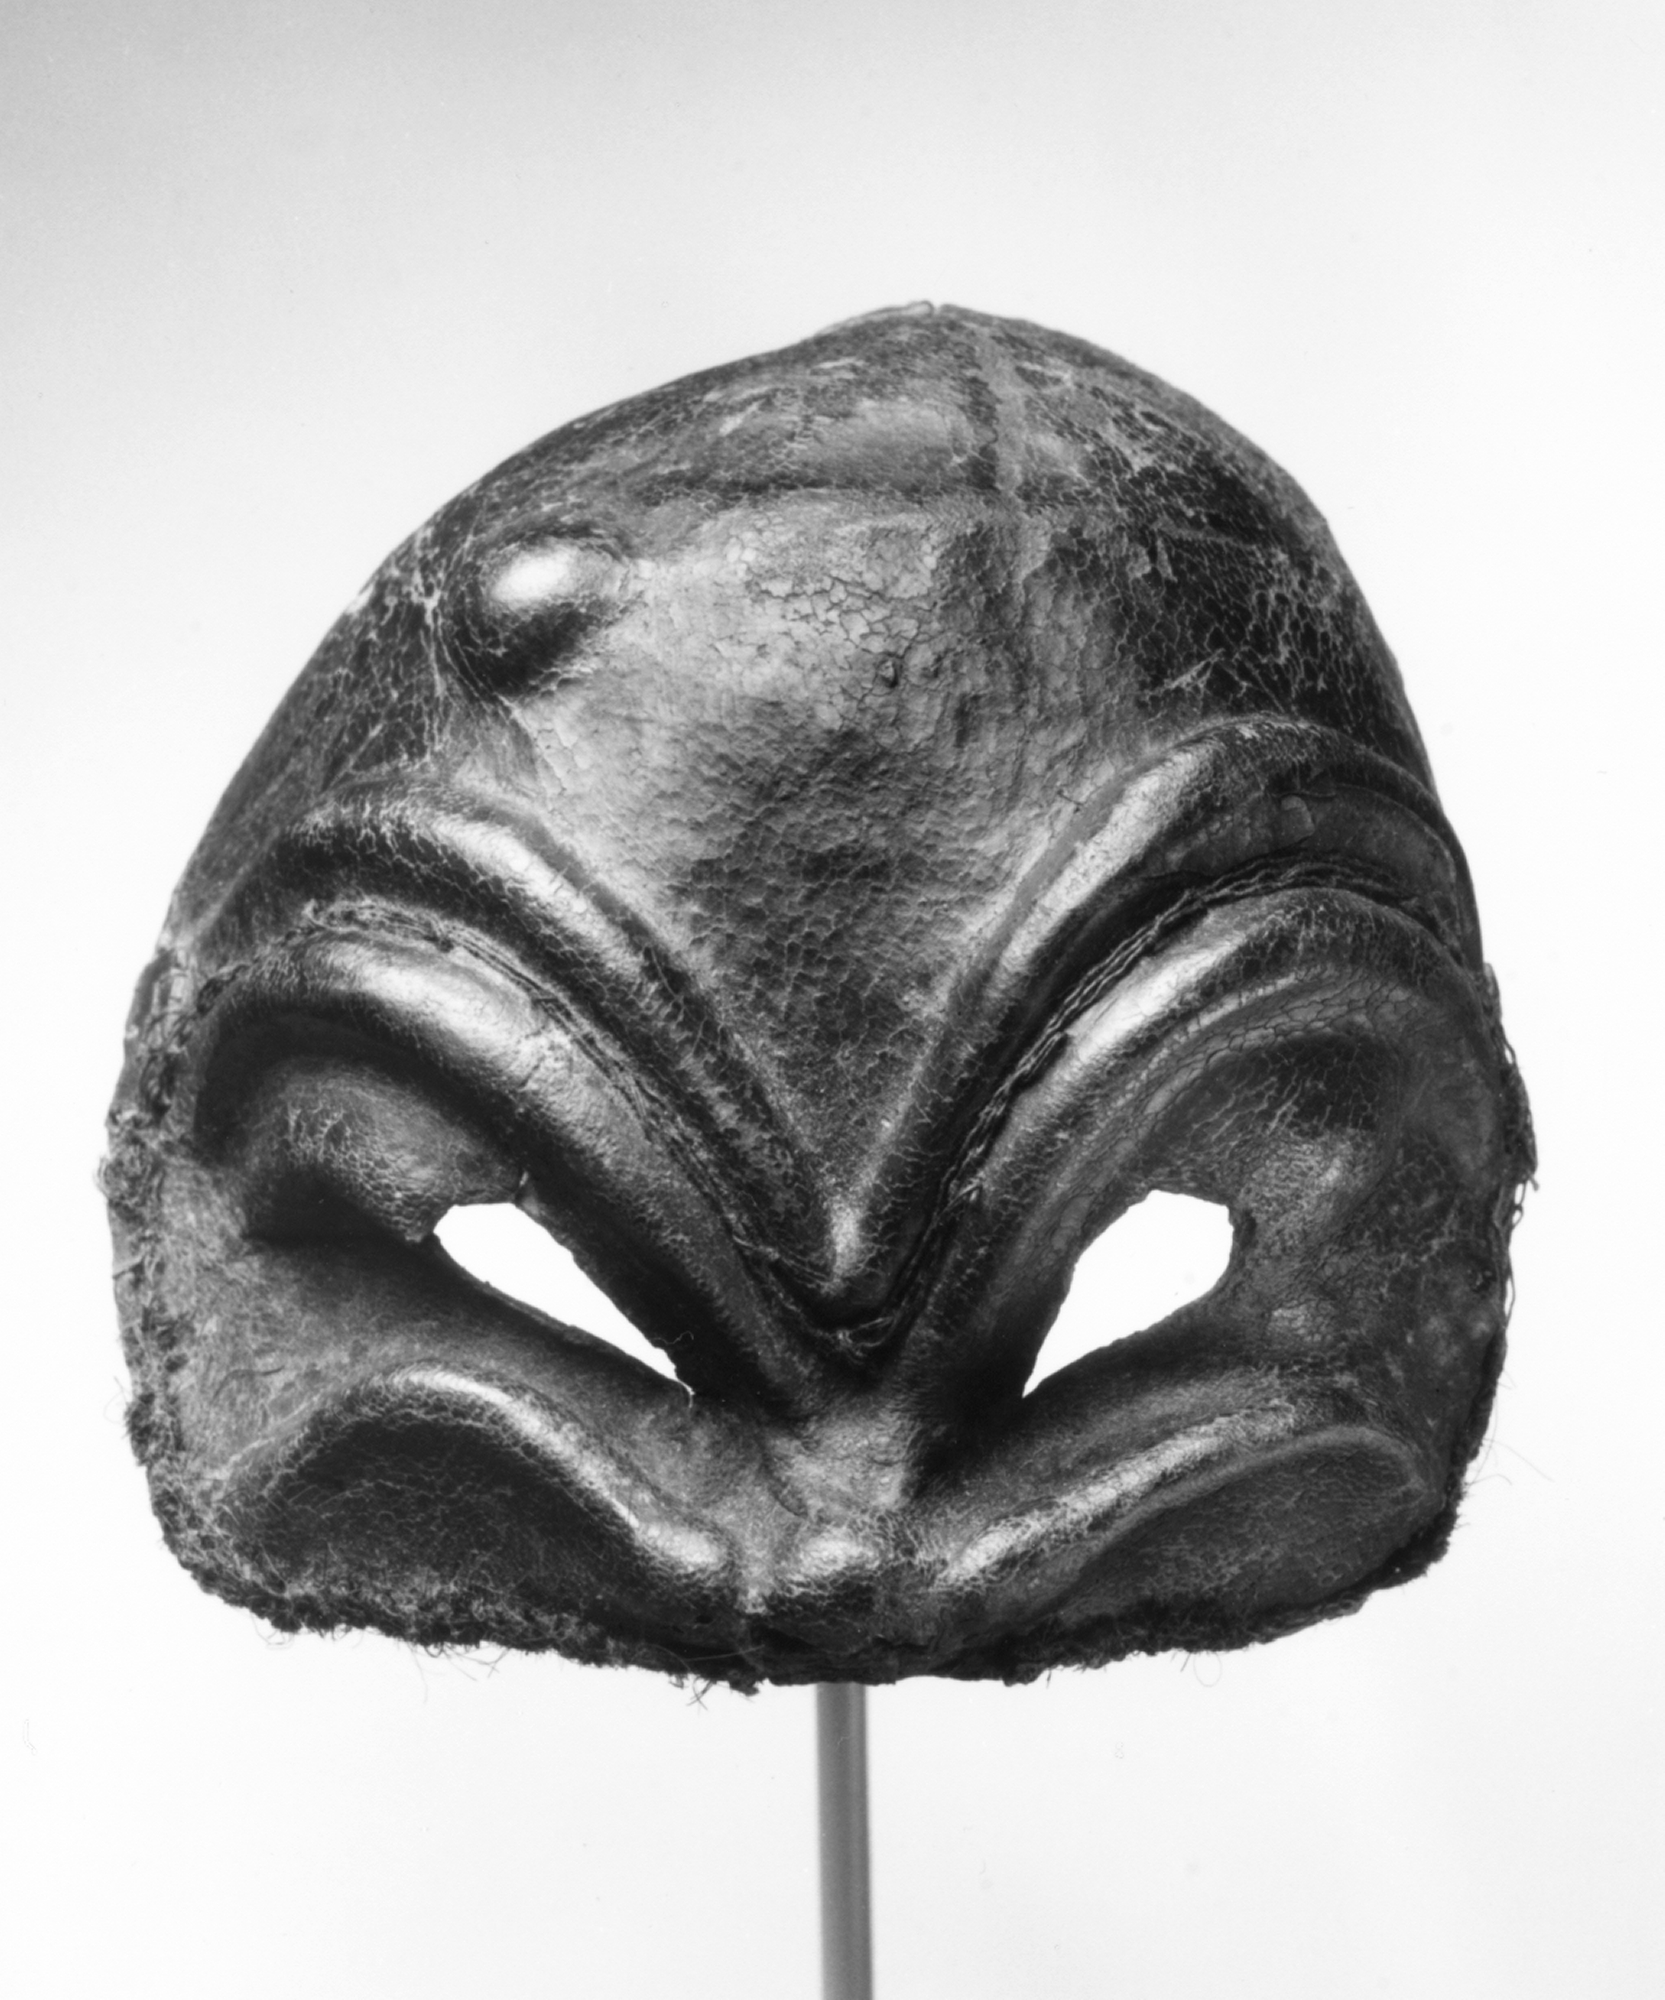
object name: mask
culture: european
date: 1701-1800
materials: leather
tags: masks